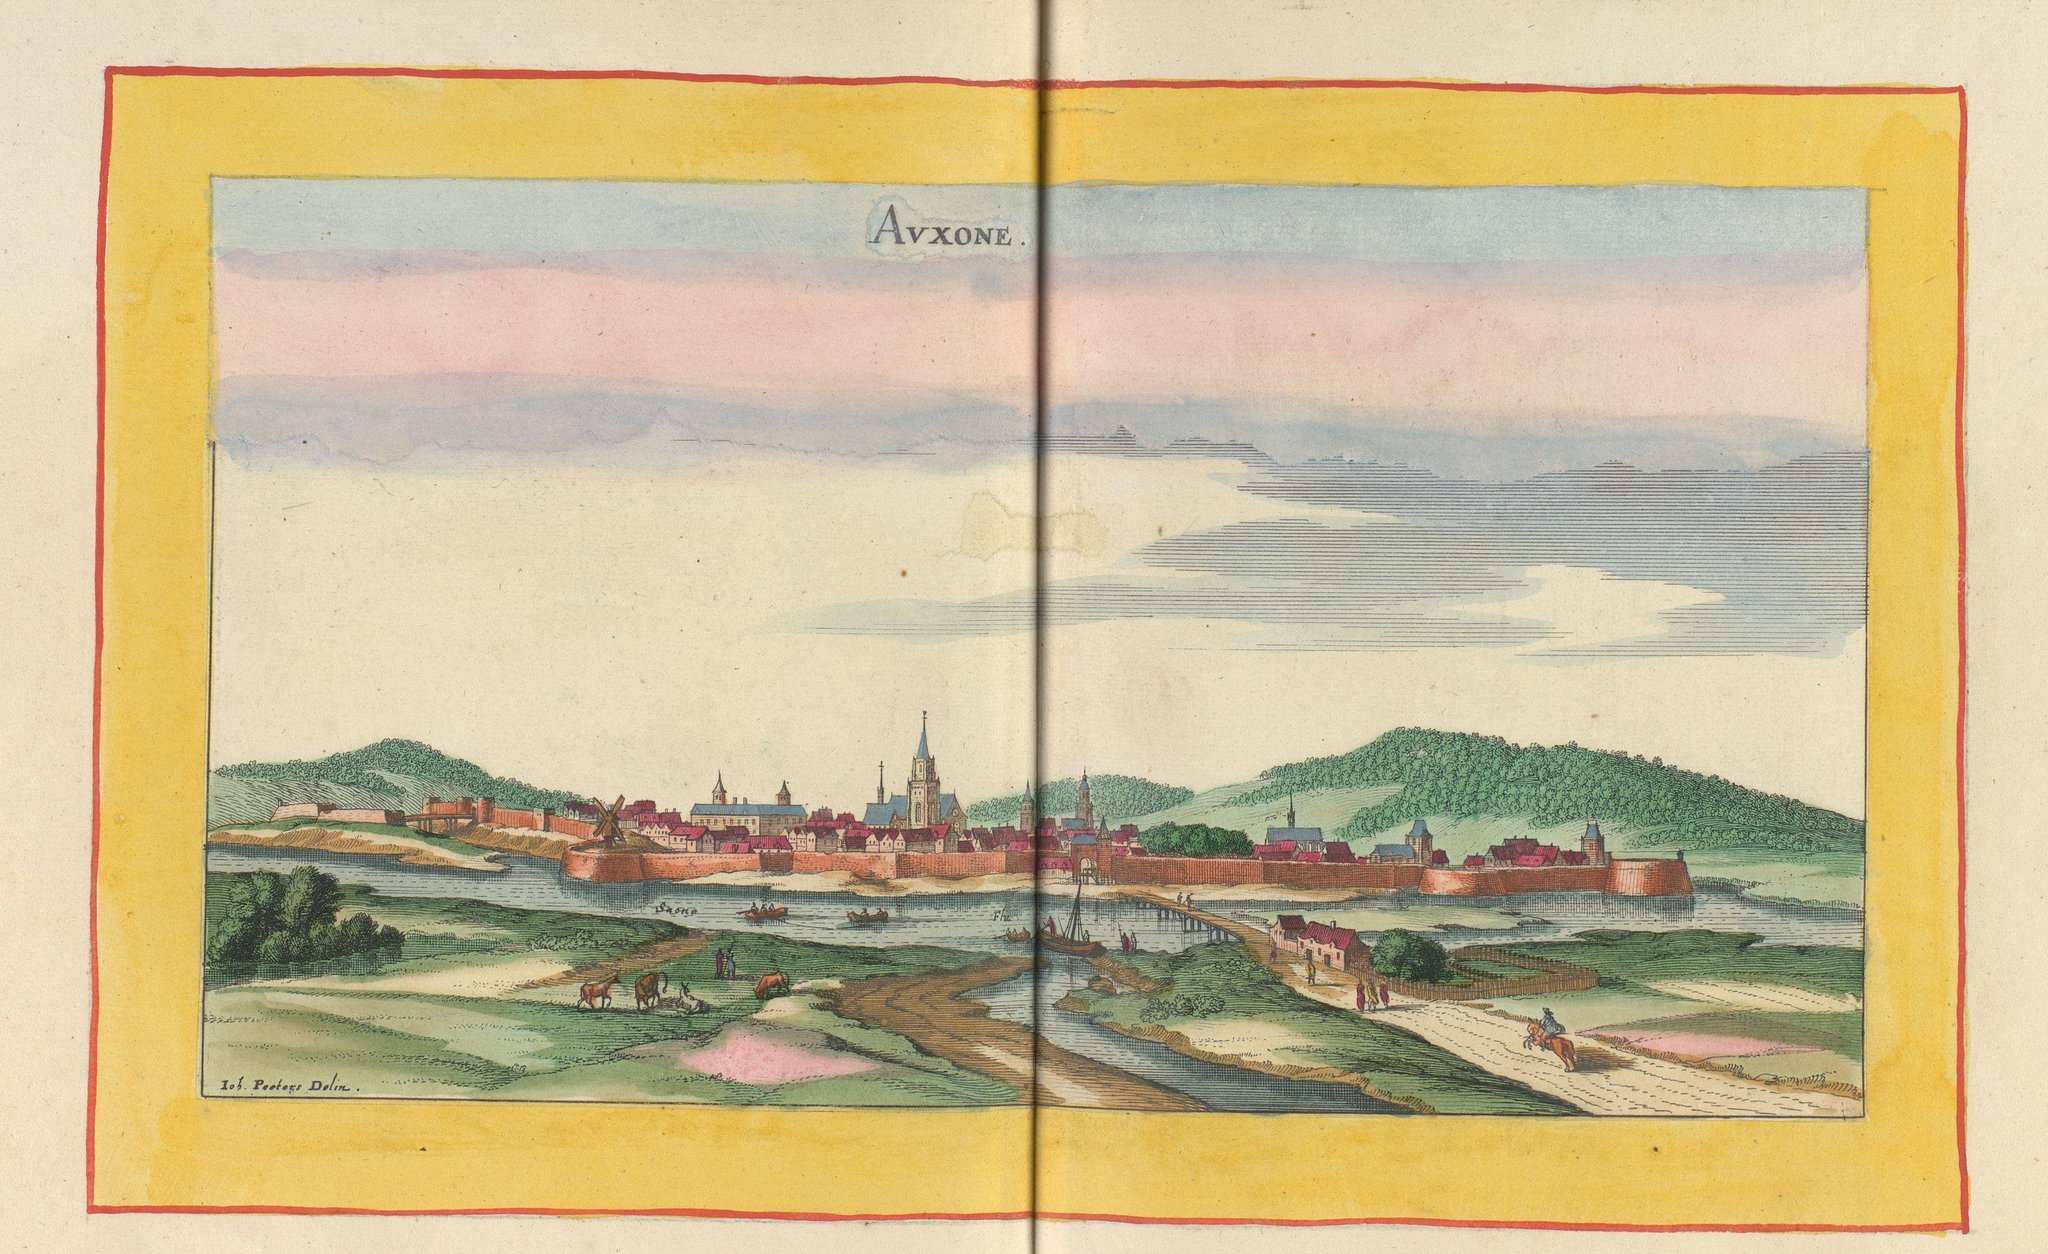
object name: print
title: Auxone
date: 1656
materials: paper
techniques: engraving, etching, hand coloring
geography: the hague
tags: city-view in general; 'veduta'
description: Prent uit: Zeiller, Martin. Topographia Galliae. 13 dln. Frankfurt: Caspar Merian, 1656, dl. 4, na p. 6. De titel is uit de originele prent gesneden. Boven de gravure is een deel lucht en wolken (bij)geschilderd, waarin de titel gelijmd is. Origineel op één blad gedrukt met een gezicht op Auxonne (RP-P-1957-607-54-2).